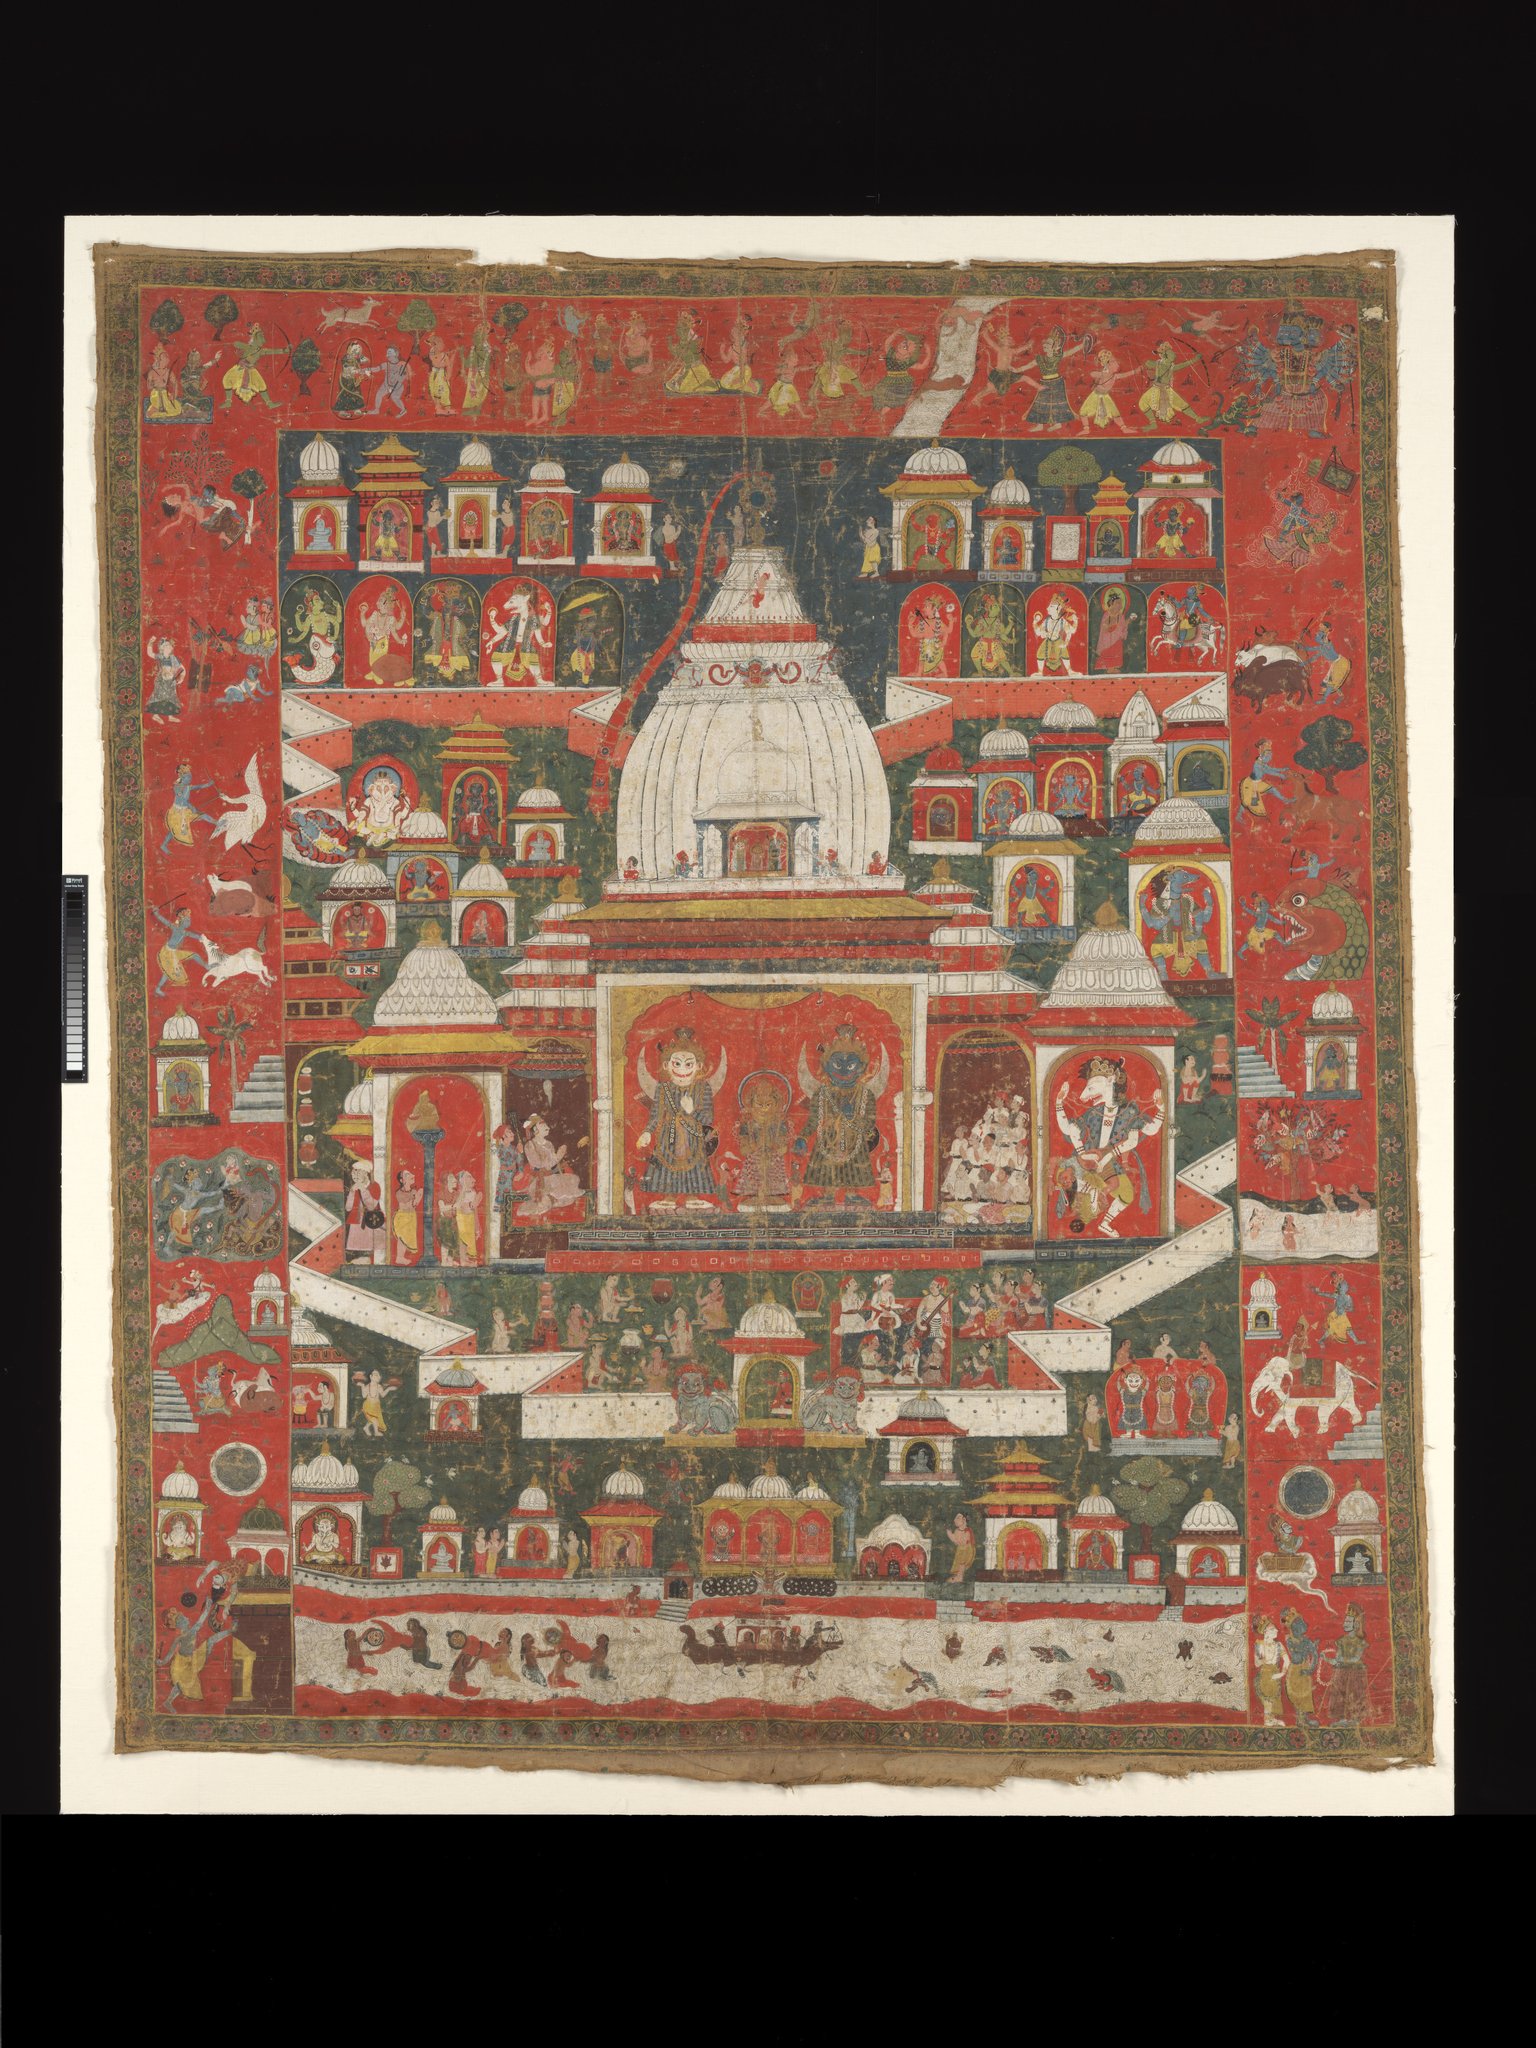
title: Worship of Lord Jagannatha in His Temple at Puri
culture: nepali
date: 1701-1733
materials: cotton, pigment